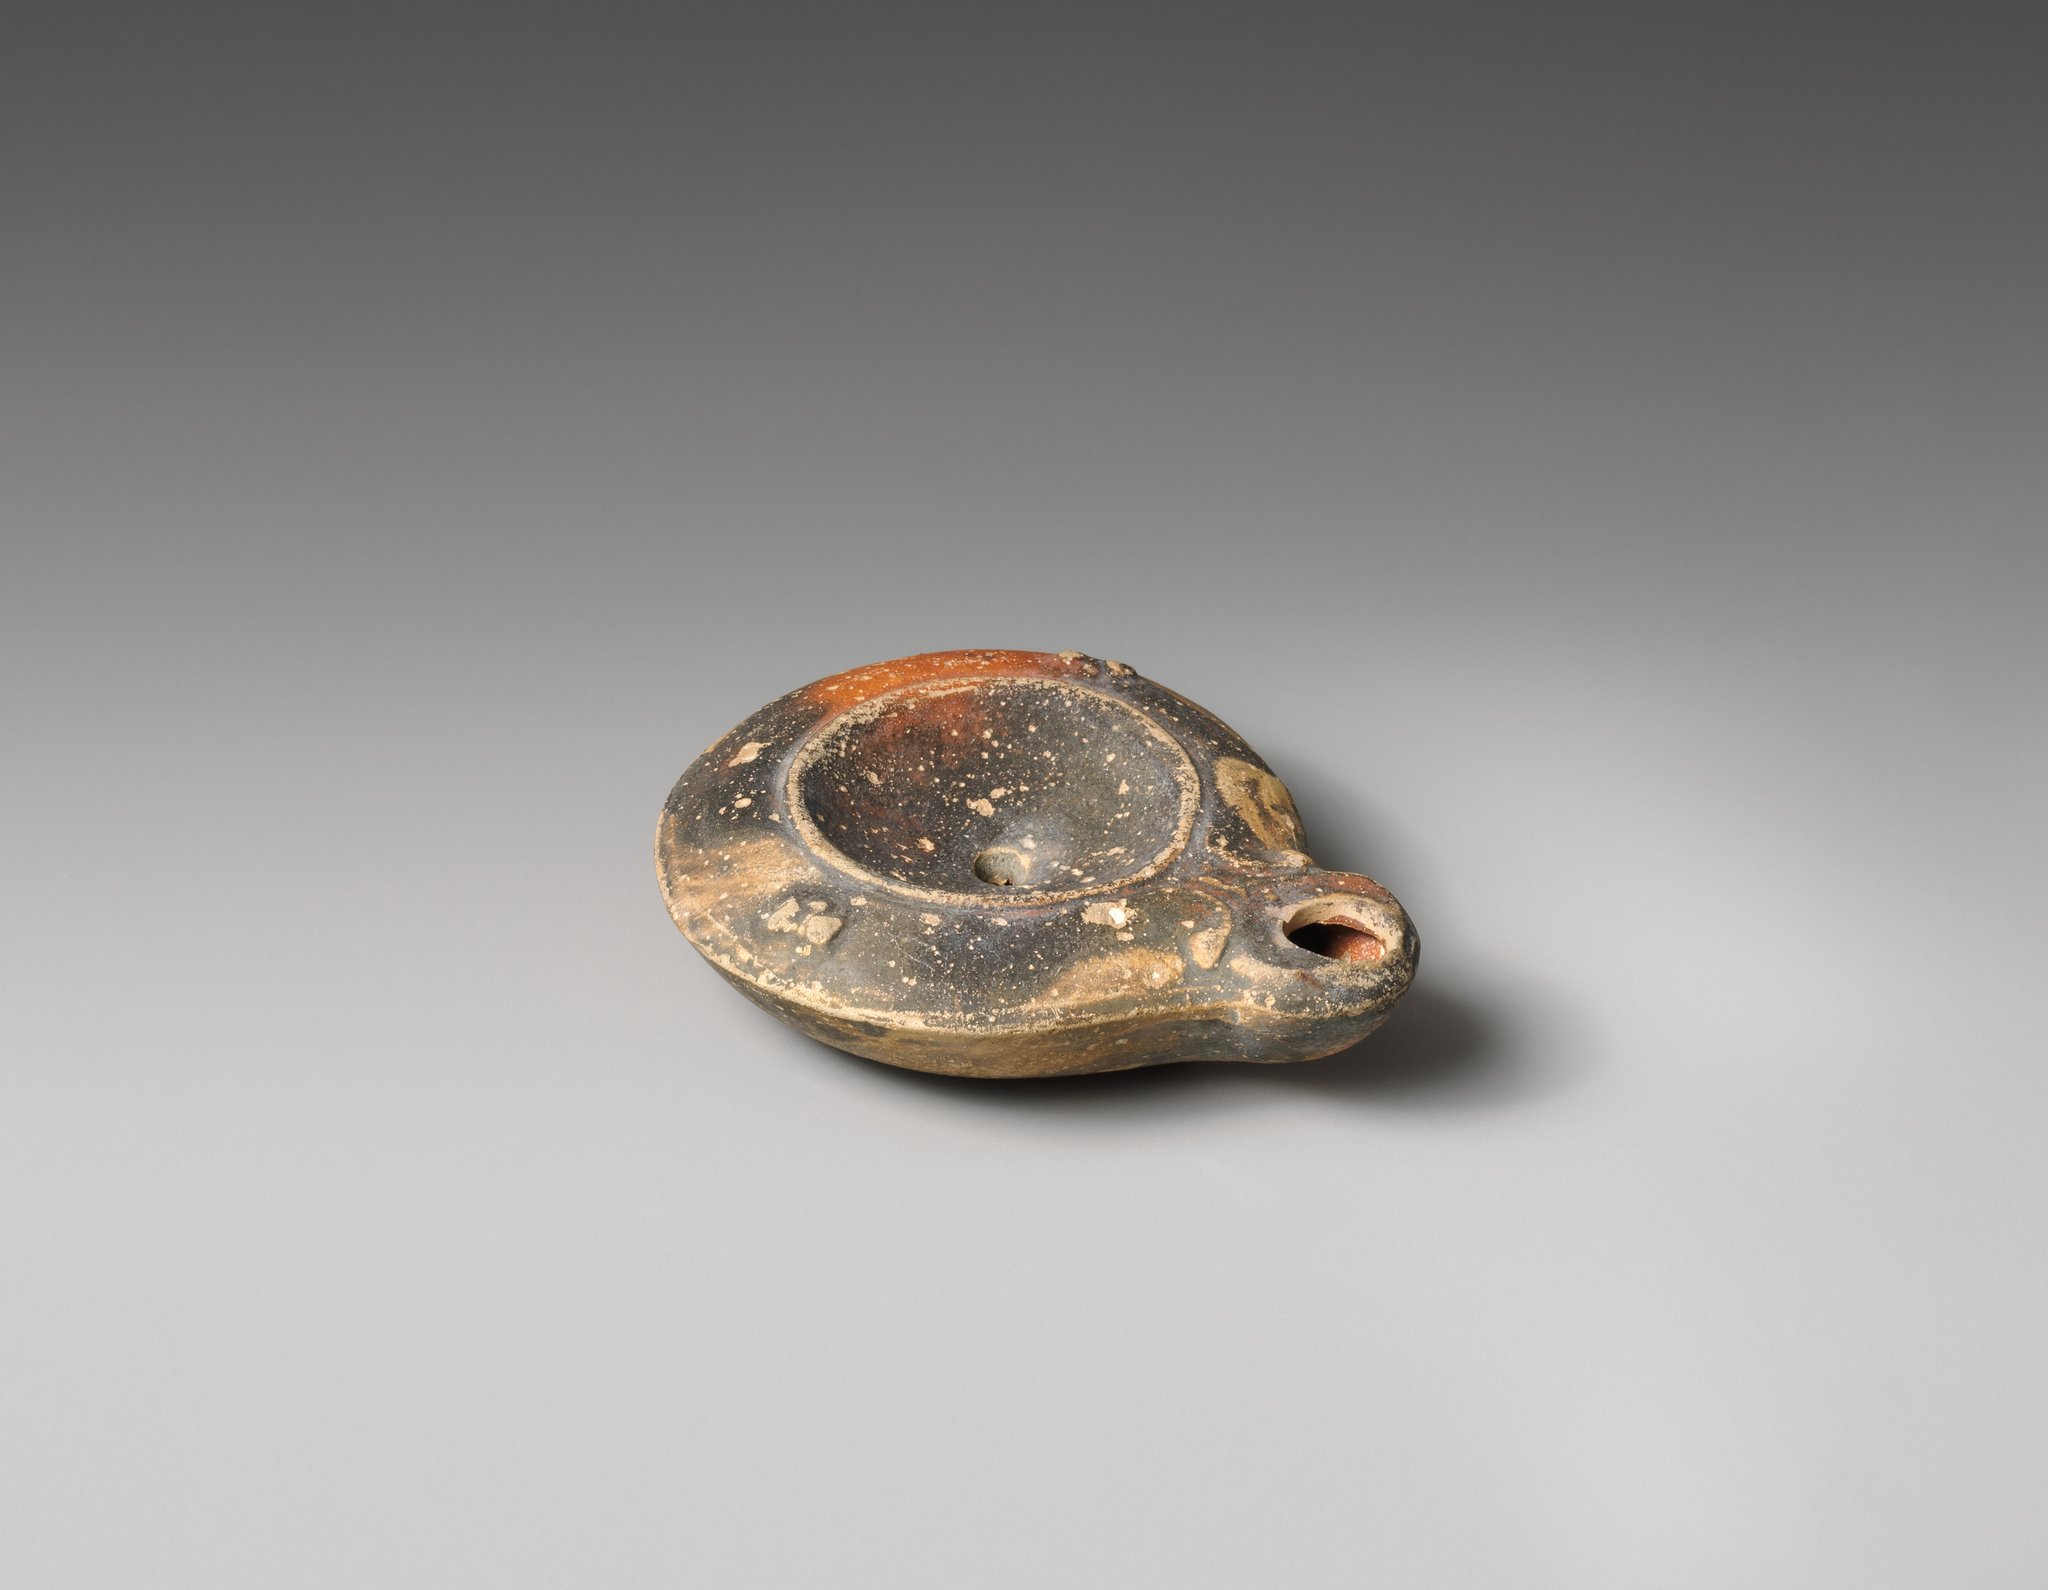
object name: lamp, concave top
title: Terracotta oil lamp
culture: roman, cypriot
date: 100 BCE-100 CE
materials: terracotta